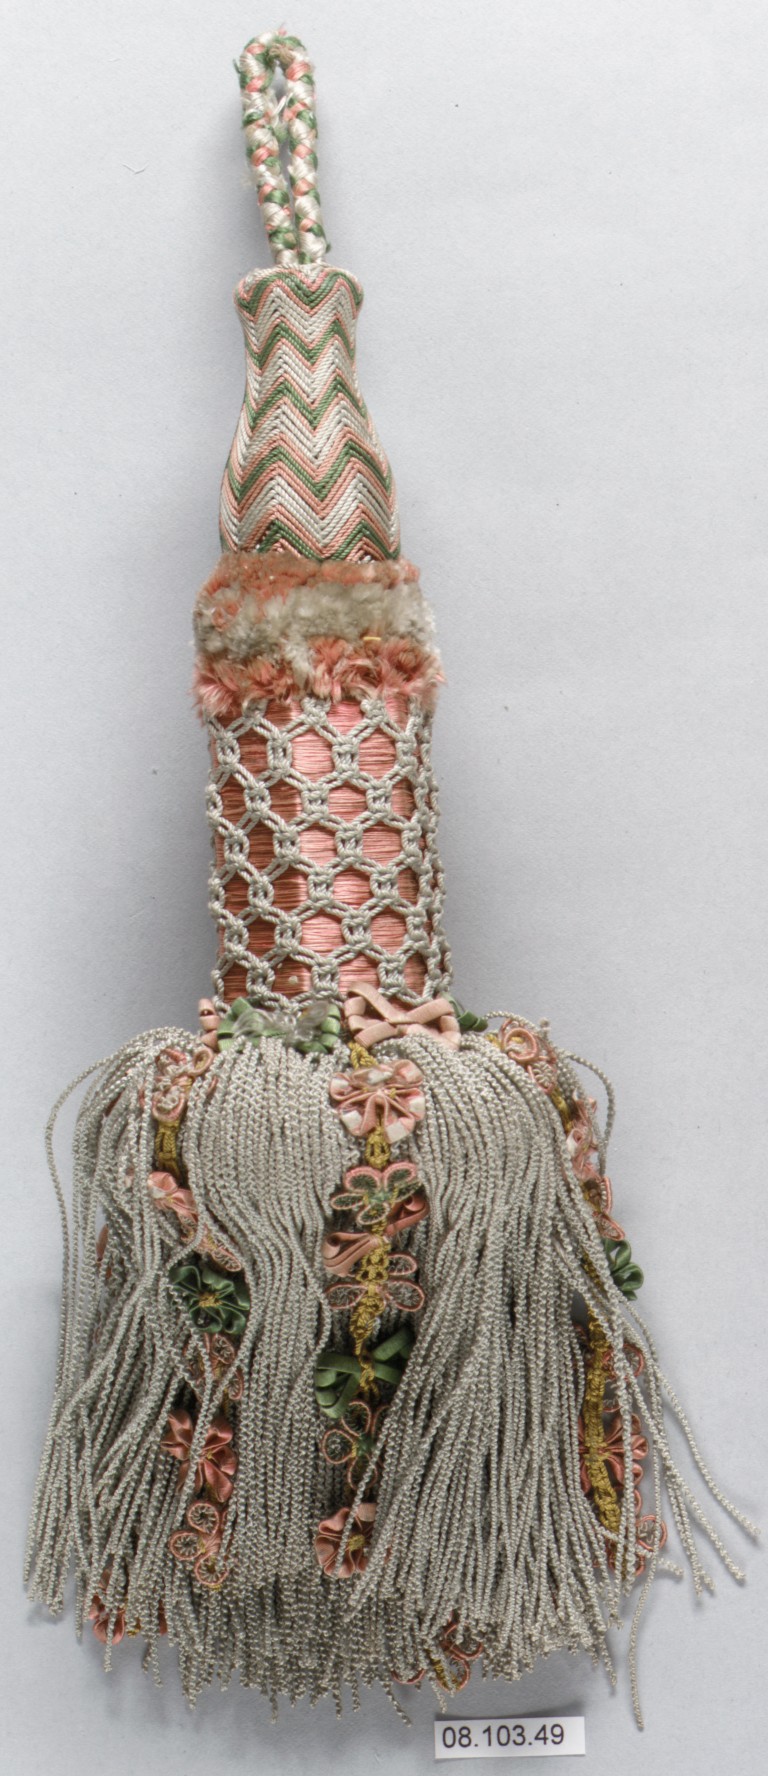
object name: tassel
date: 1801-1900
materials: silk